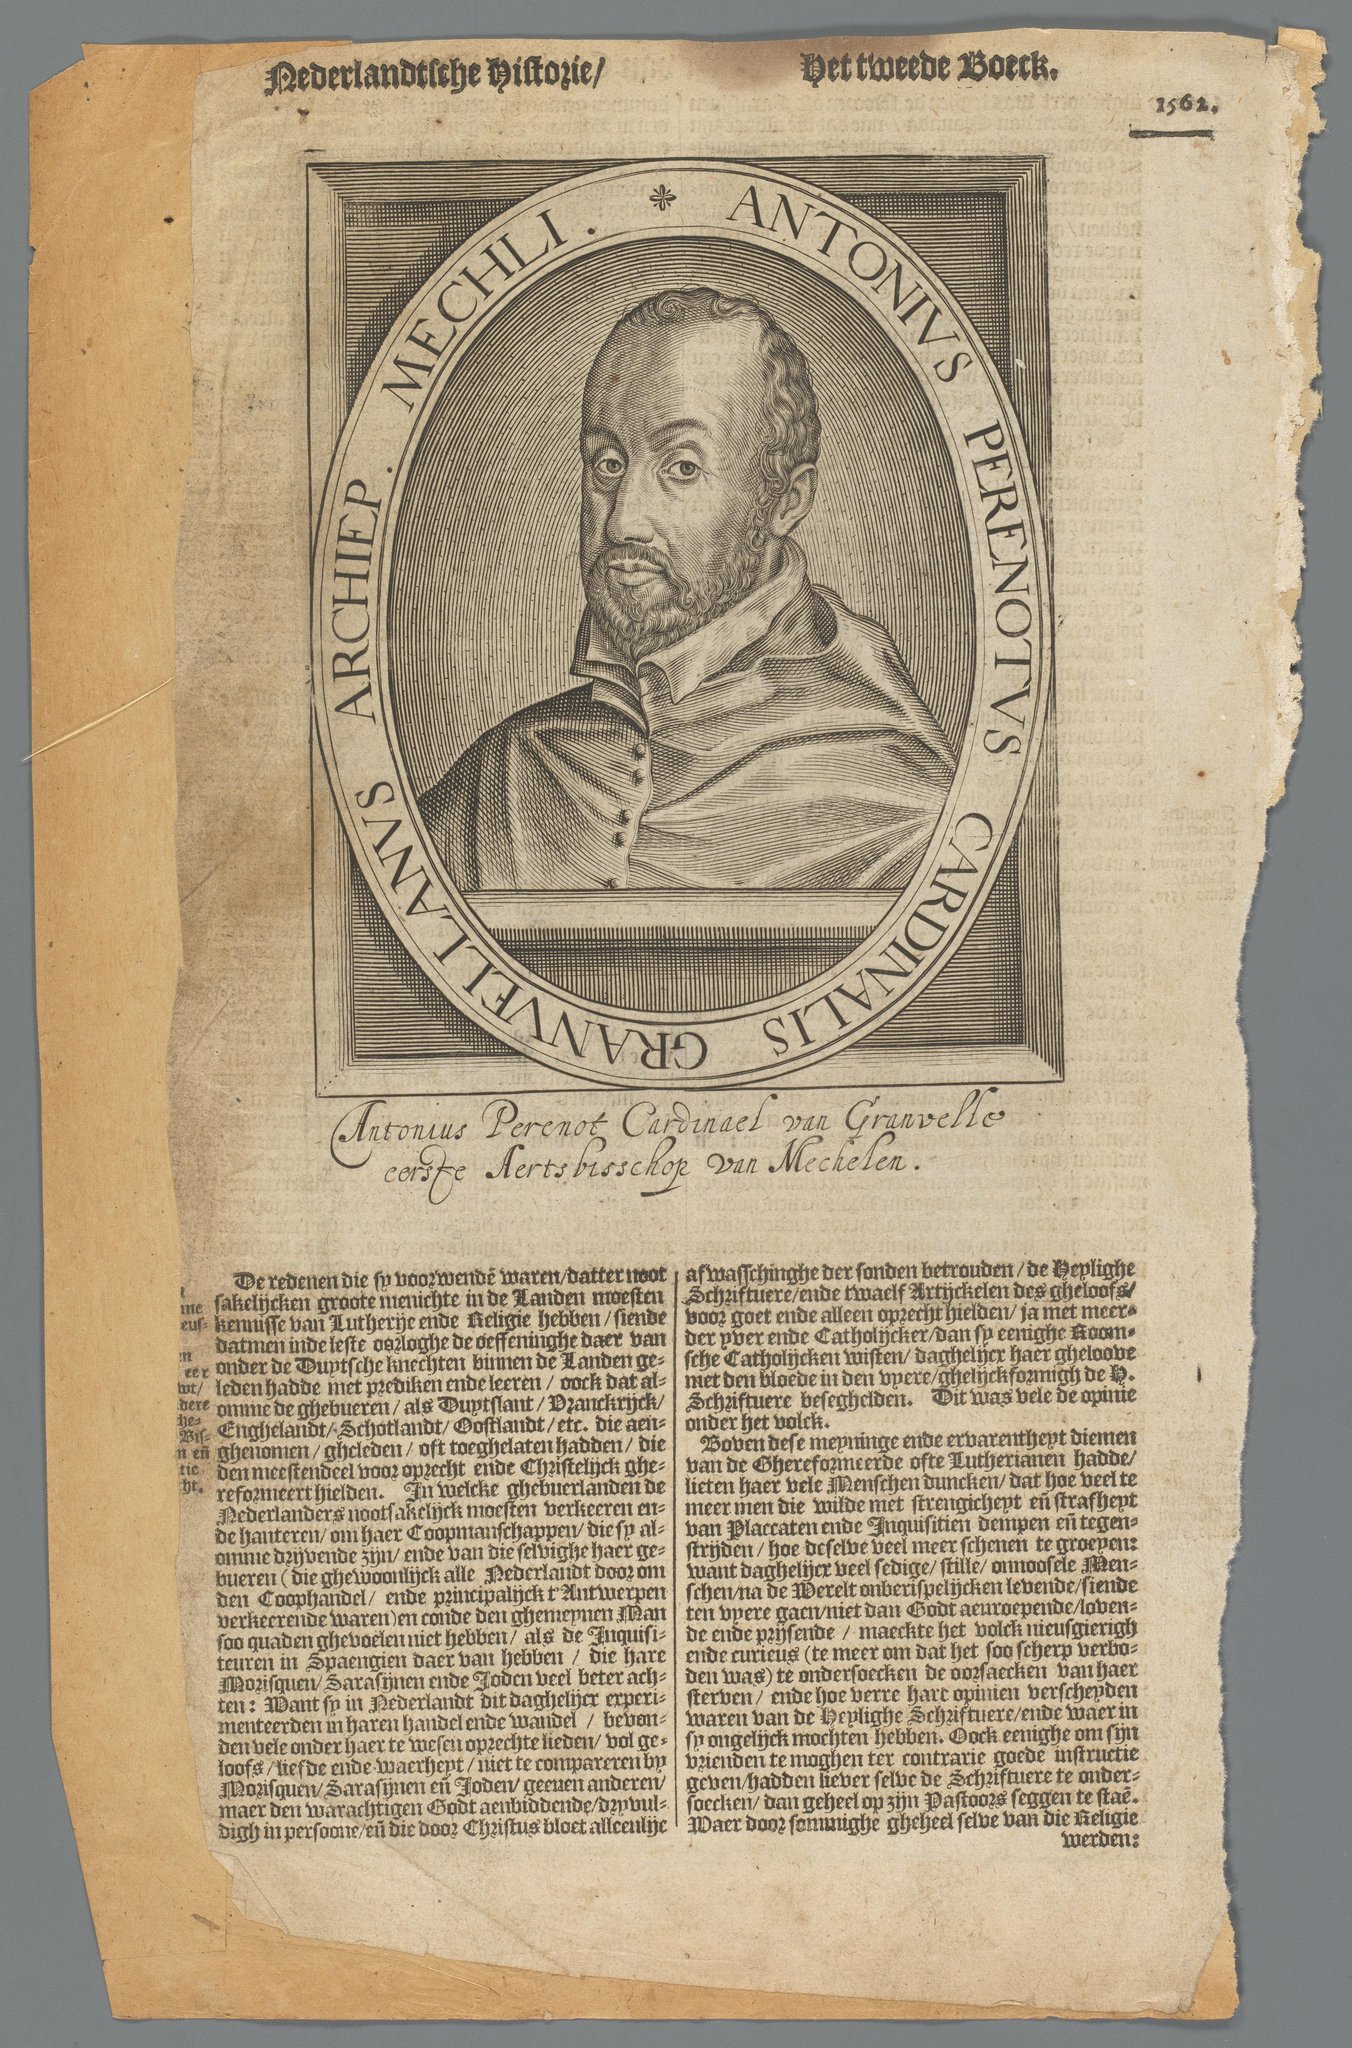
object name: print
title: Portret van Antoine Perrenot de Granvelle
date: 1614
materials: paper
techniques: engraving, letterpress printing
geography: the hague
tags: antoine perrenot de granvelle, cardinal, historical persons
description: Prent uit: Meteren, Emanuel van. Historie der Nederlandscher ende haerder na-buren oorlogen ende geschiedenissen (...). Den Haag: Hillebrant Iacobsz. van Wouw, 1614. Prent ook gebruikt in: Meteren, Emanuel van. Historie der Nederlandscher ende haerder na-buren oorlogen ende geschiedenissen (...). Den Haag: weduwe en erfgenamen van Hillebrant Iacobsz. van Wouw, 1623. Prent mogelijk ook gebruikt in latere edities.